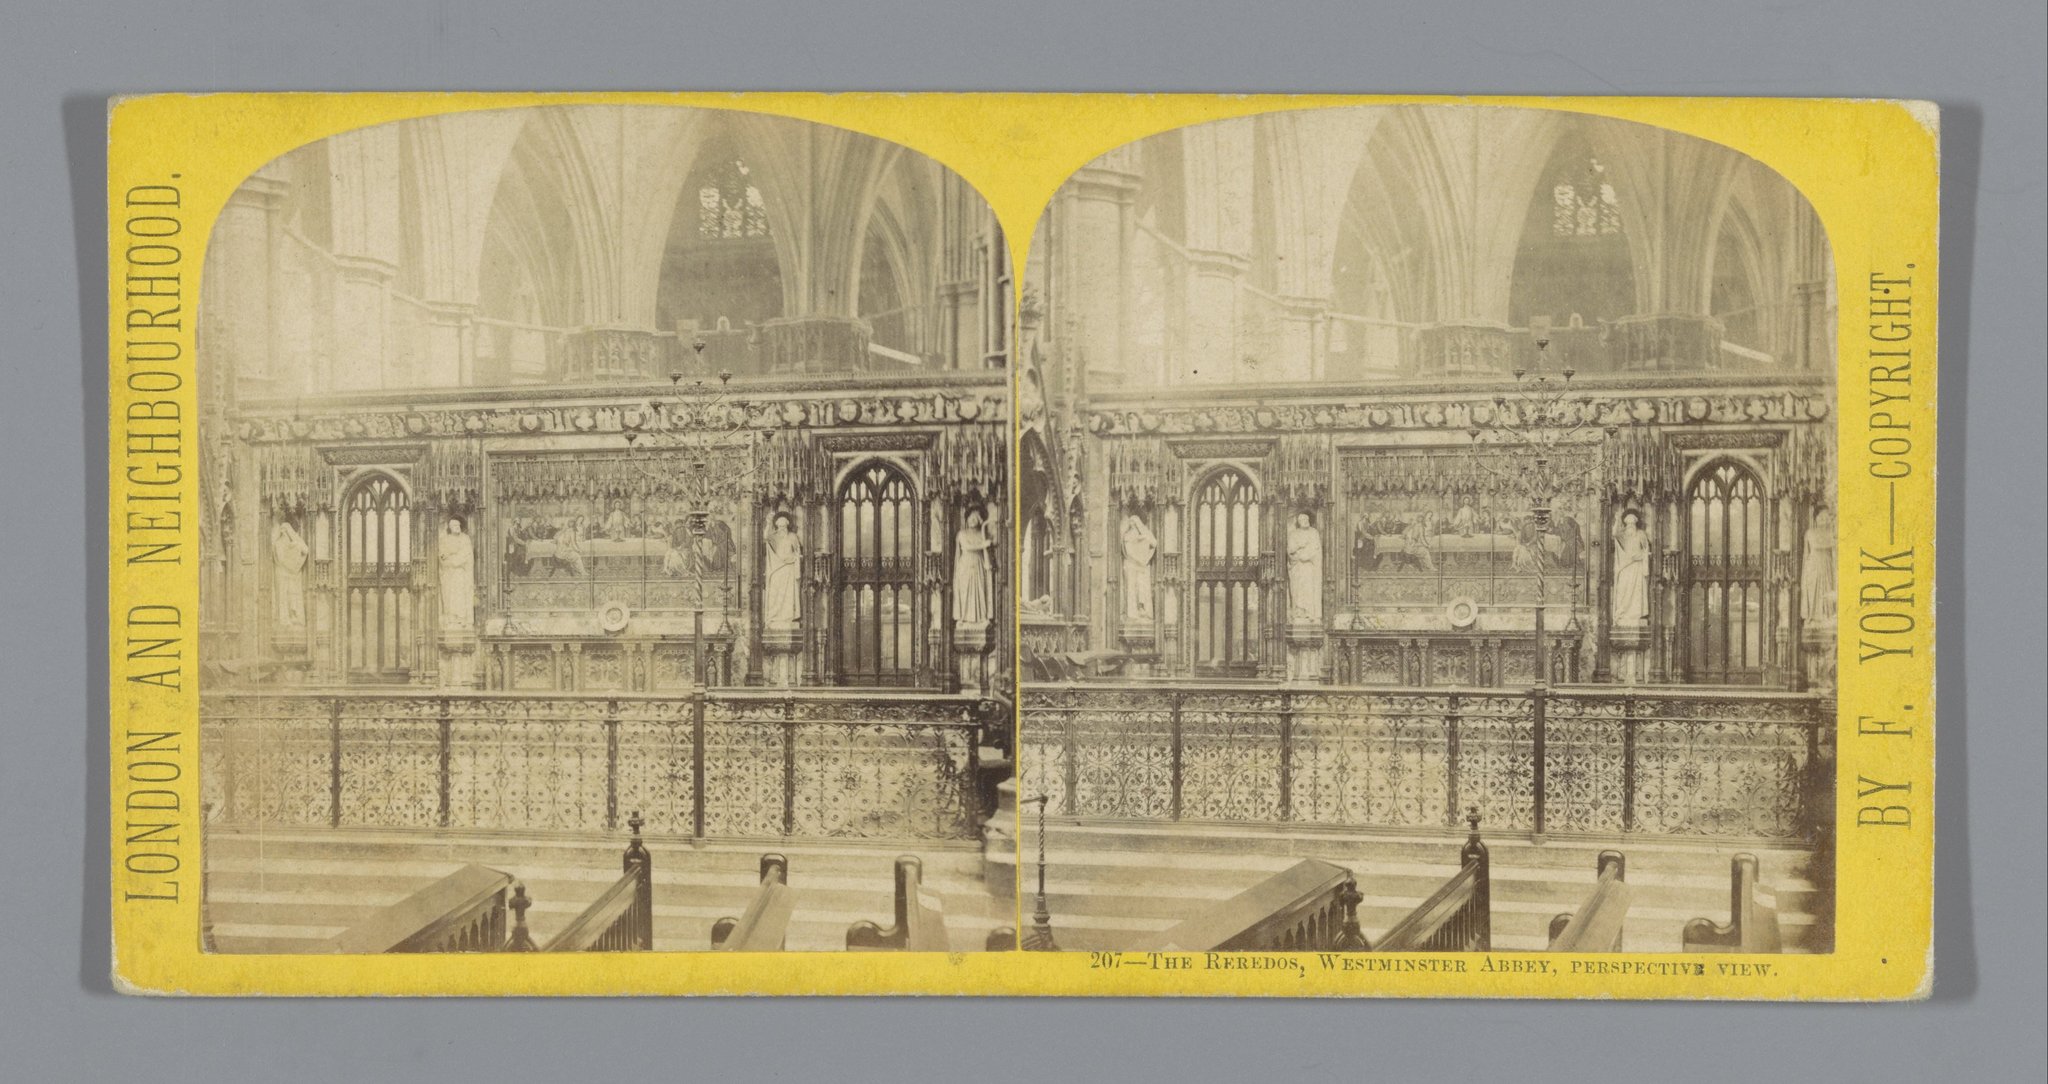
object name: stereograph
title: The Reredos, Westminster Abbey, perspective view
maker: frederick york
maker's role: fotograaf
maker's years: 1823-1903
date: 1860-1880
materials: cardboard, photographic support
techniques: albumen print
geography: westminster abbey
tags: altar with altar-piece, westminster abbey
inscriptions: number: ‘207’